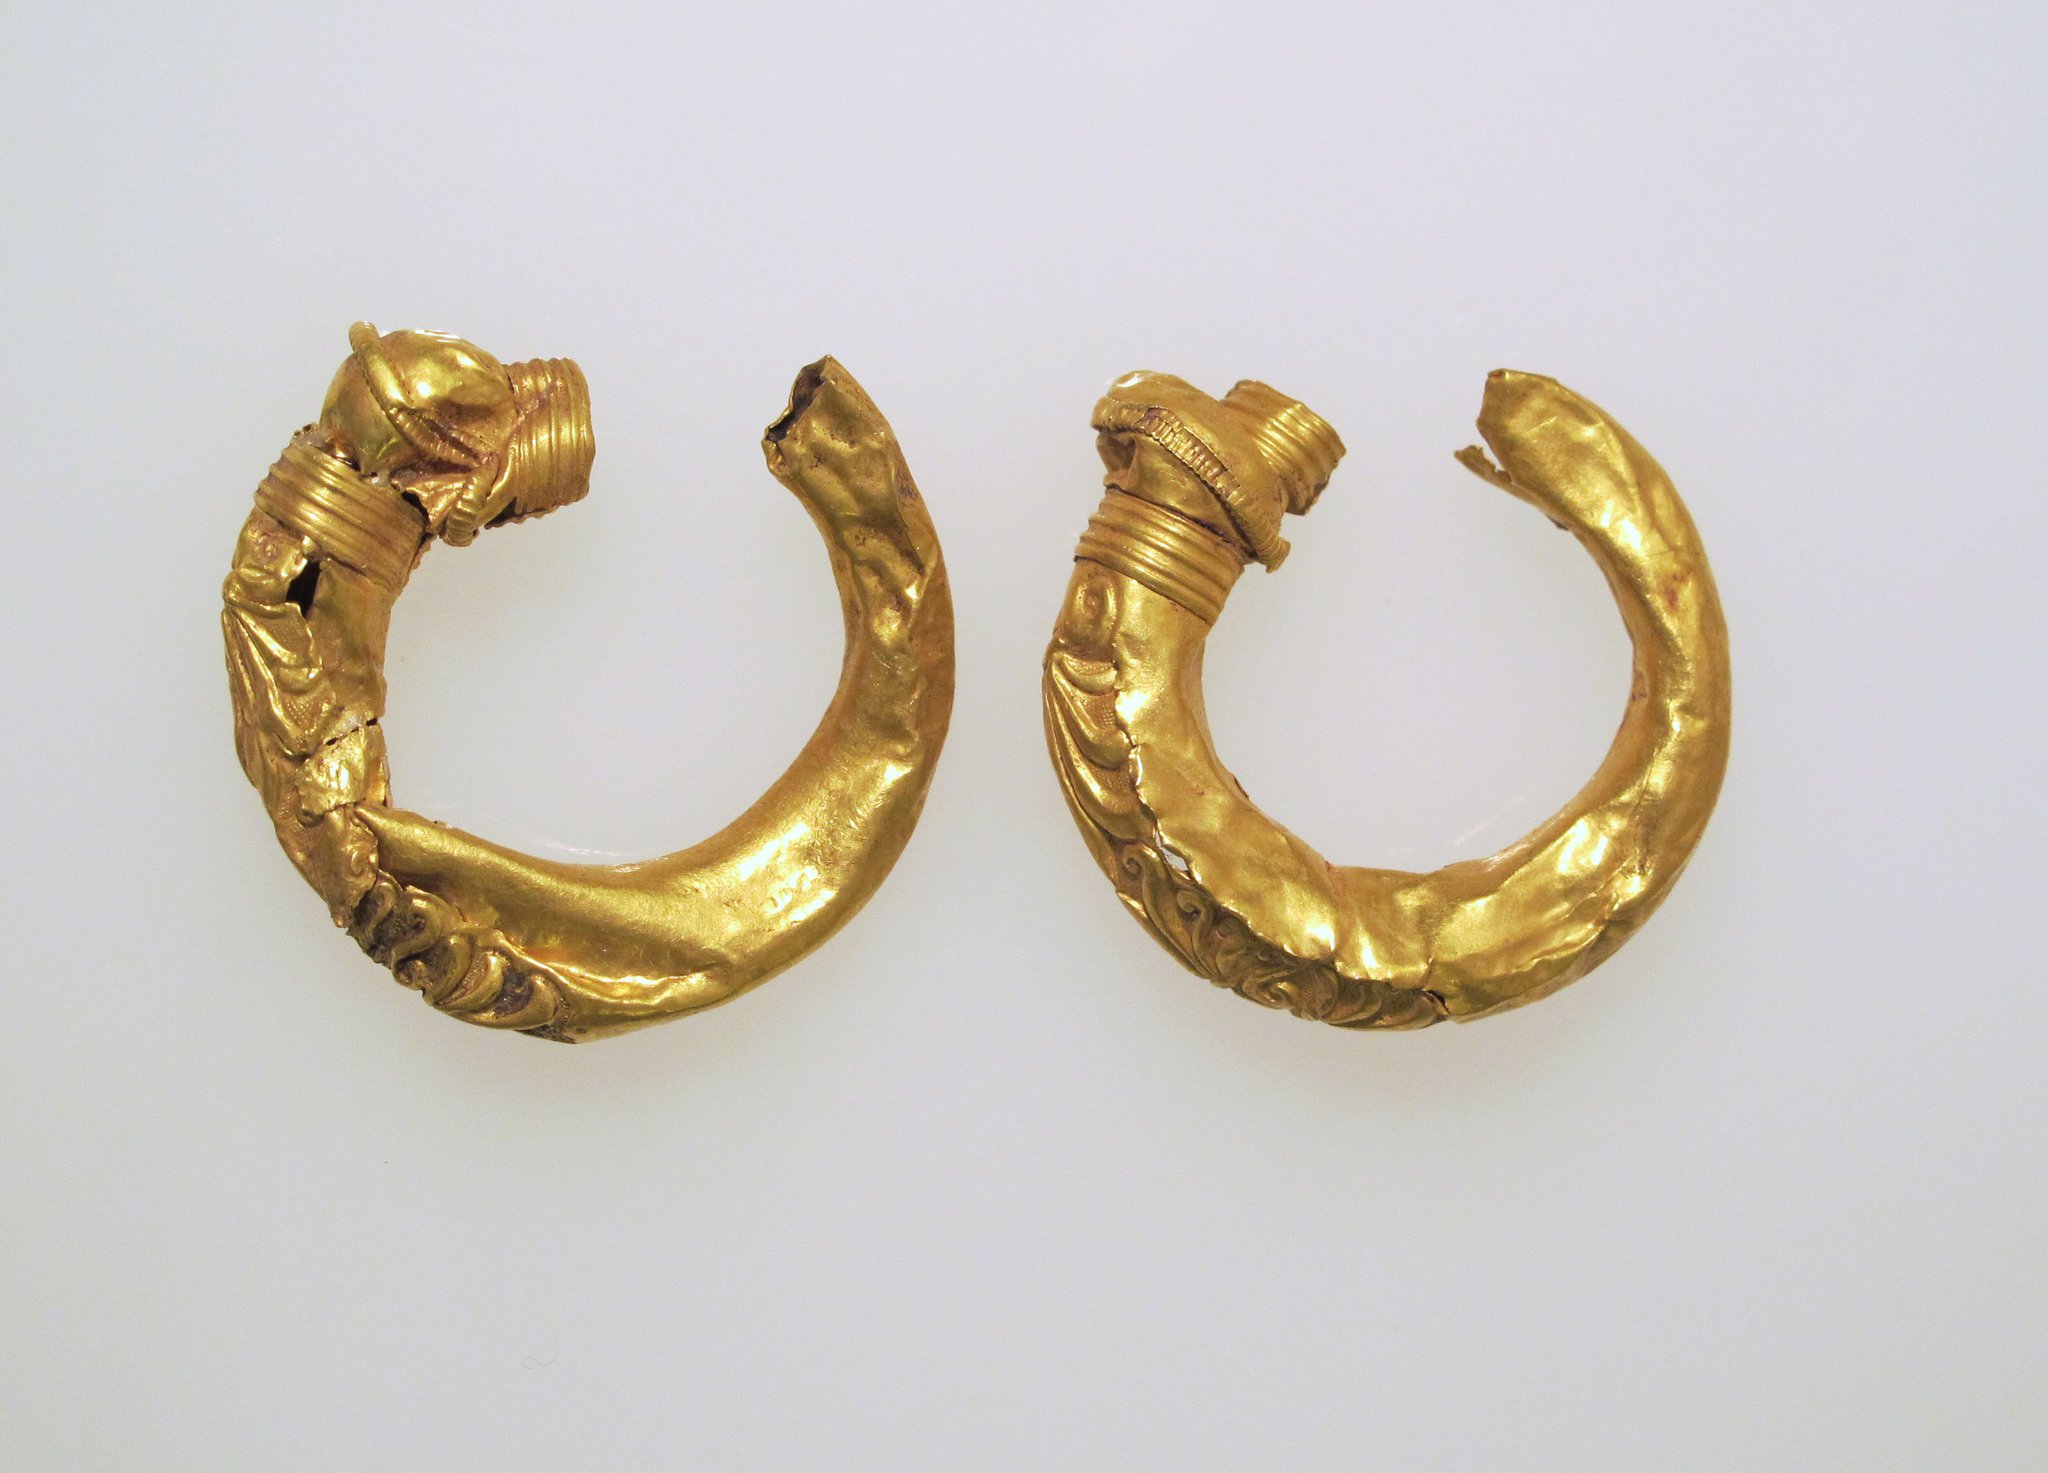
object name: earring, trumpet shaped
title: Earring, trumpet-shaped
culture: etruscan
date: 500-201 BCE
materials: gold